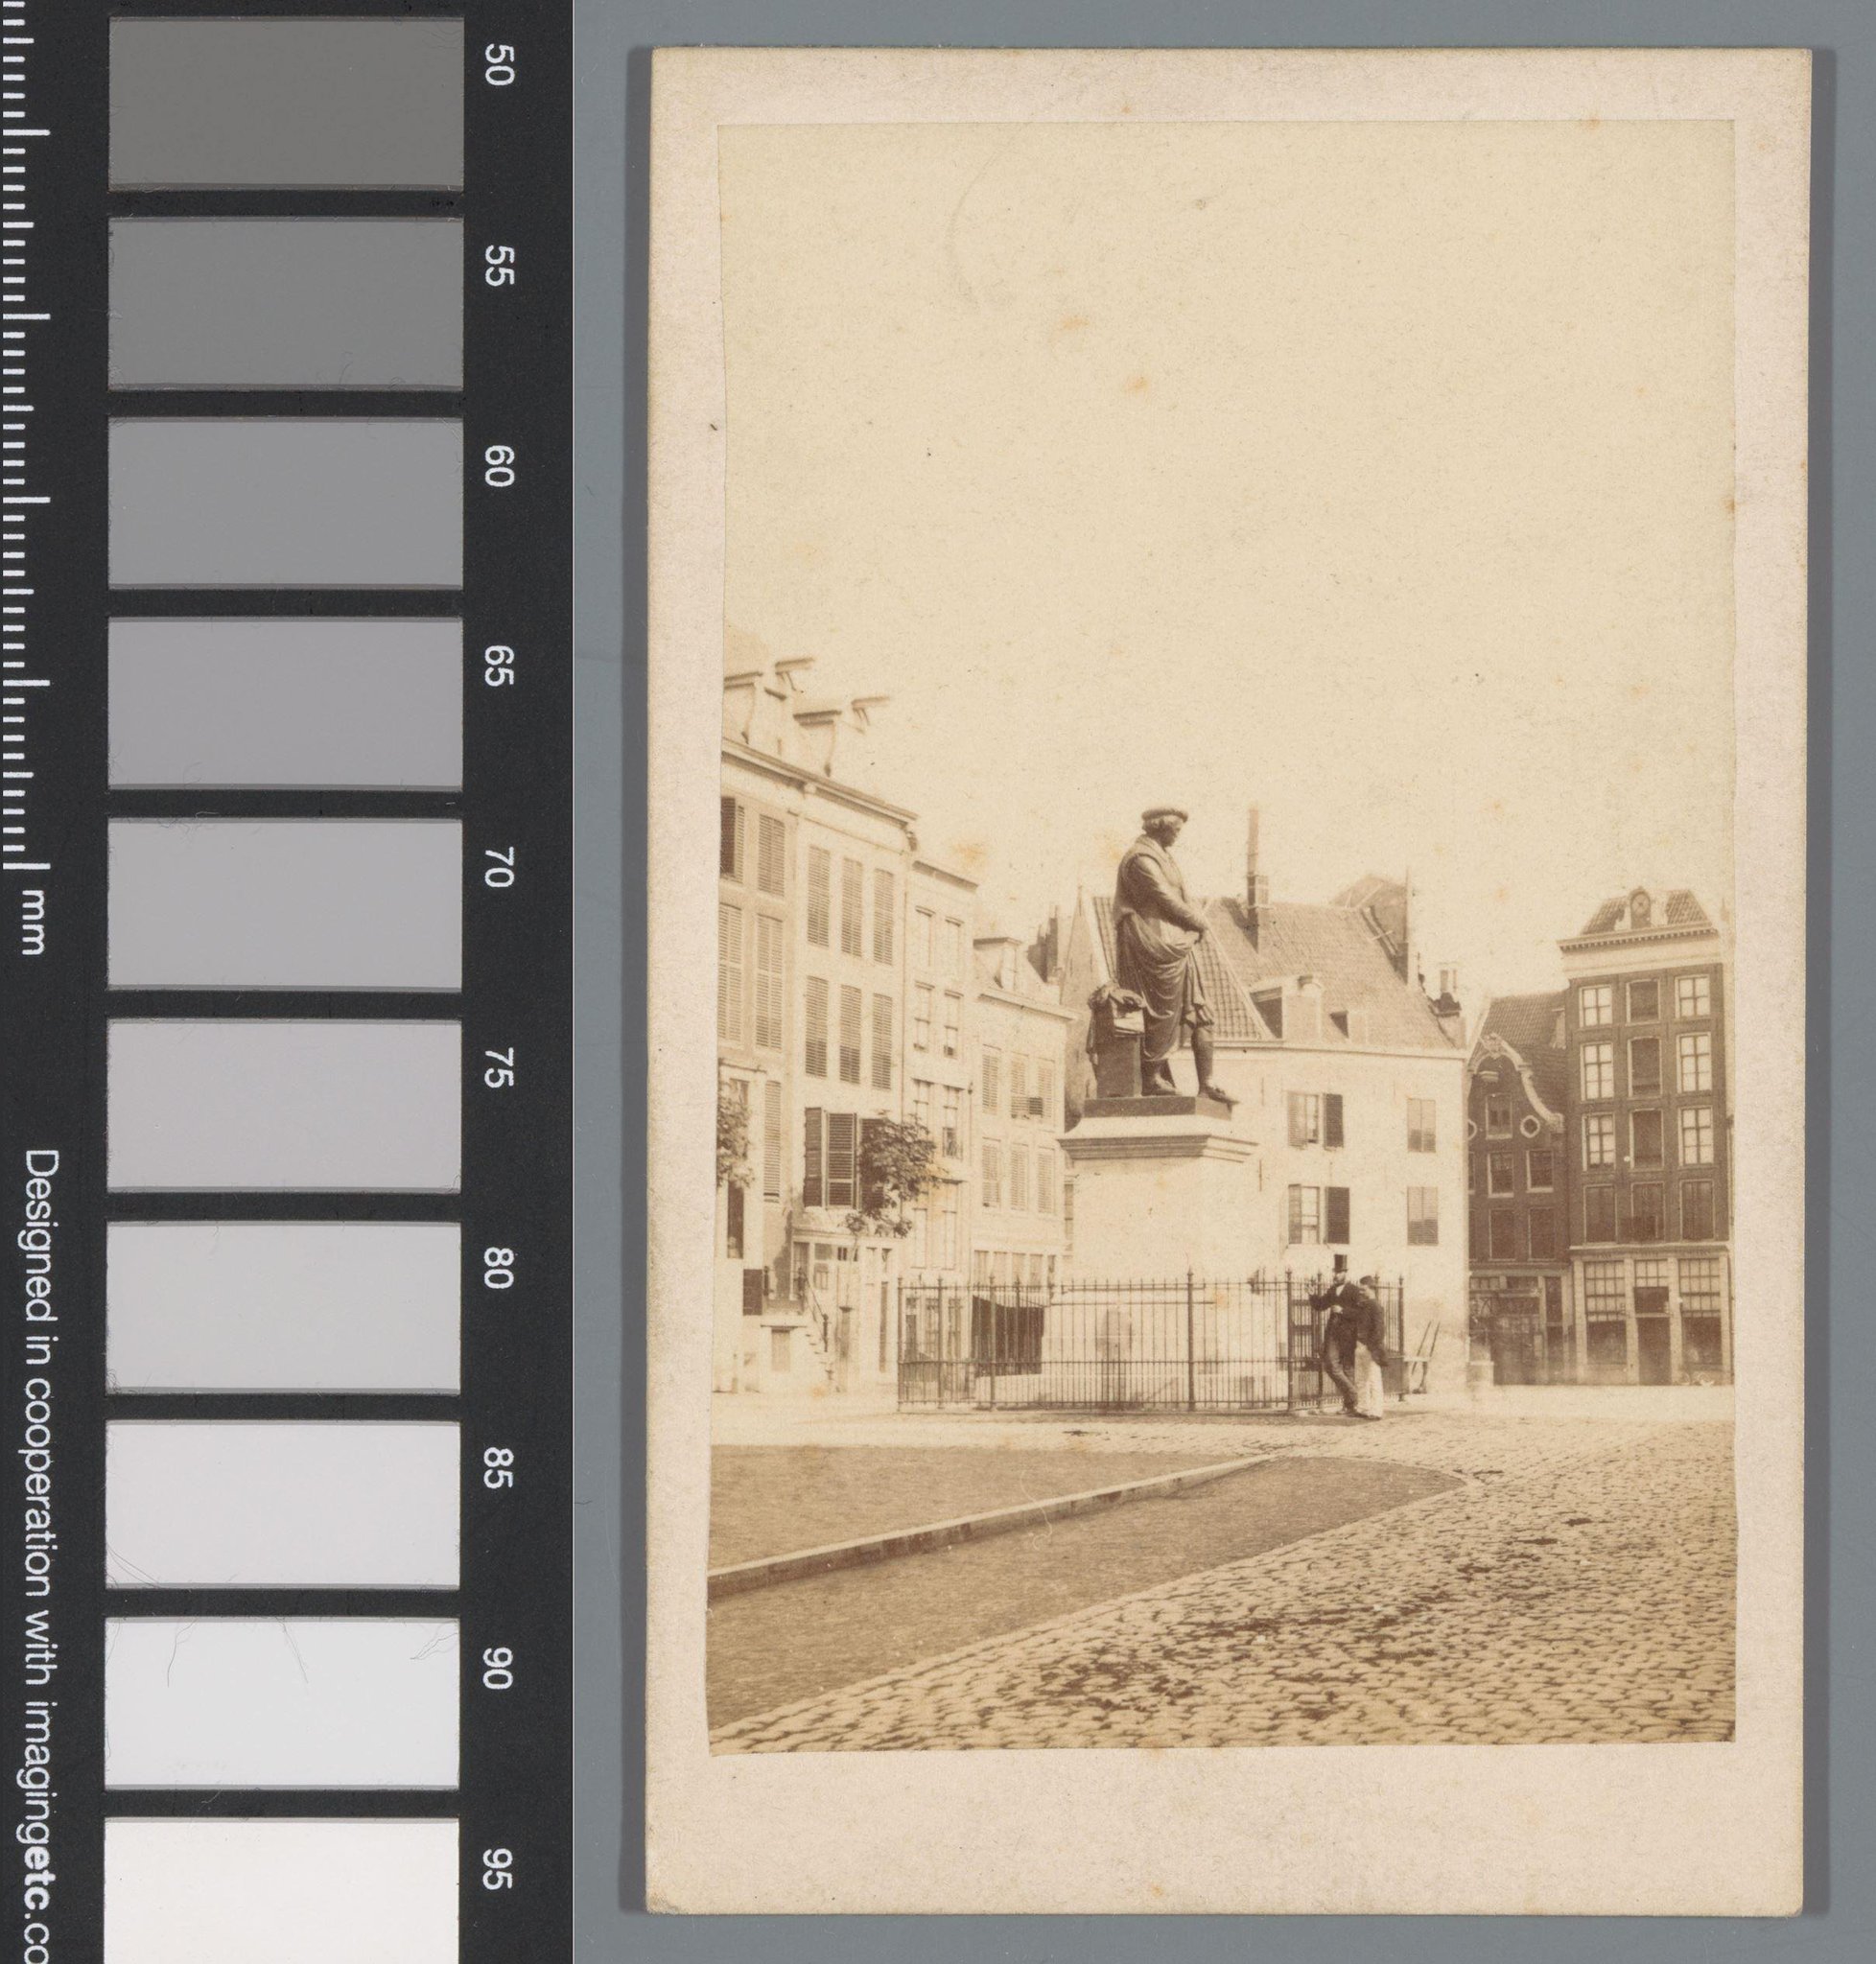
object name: carte de visite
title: Standbeeld van Rembrandt op het Rembrandtplein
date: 1859-1865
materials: cardboard, paper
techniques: albumen print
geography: amsterdam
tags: leiden, amsterdam, painter, print maker, draughtsman, rembrandt van rijn, monument, statue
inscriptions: stamp: ‘JDB’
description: Herdruk van een stereofoto uit de serie Vues de Hollande.